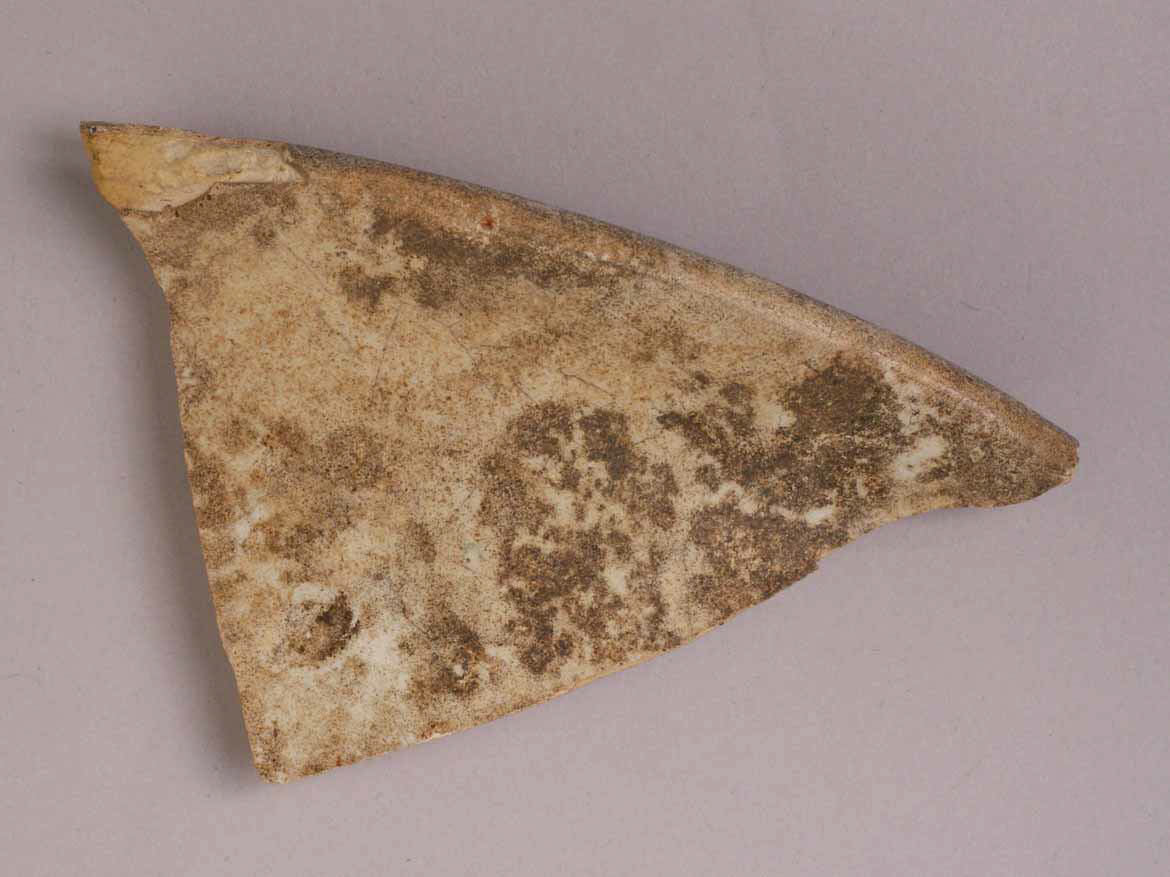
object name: fragment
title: Ceramic Fragment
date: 701-900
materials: earthenware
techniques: glazing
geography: iraq